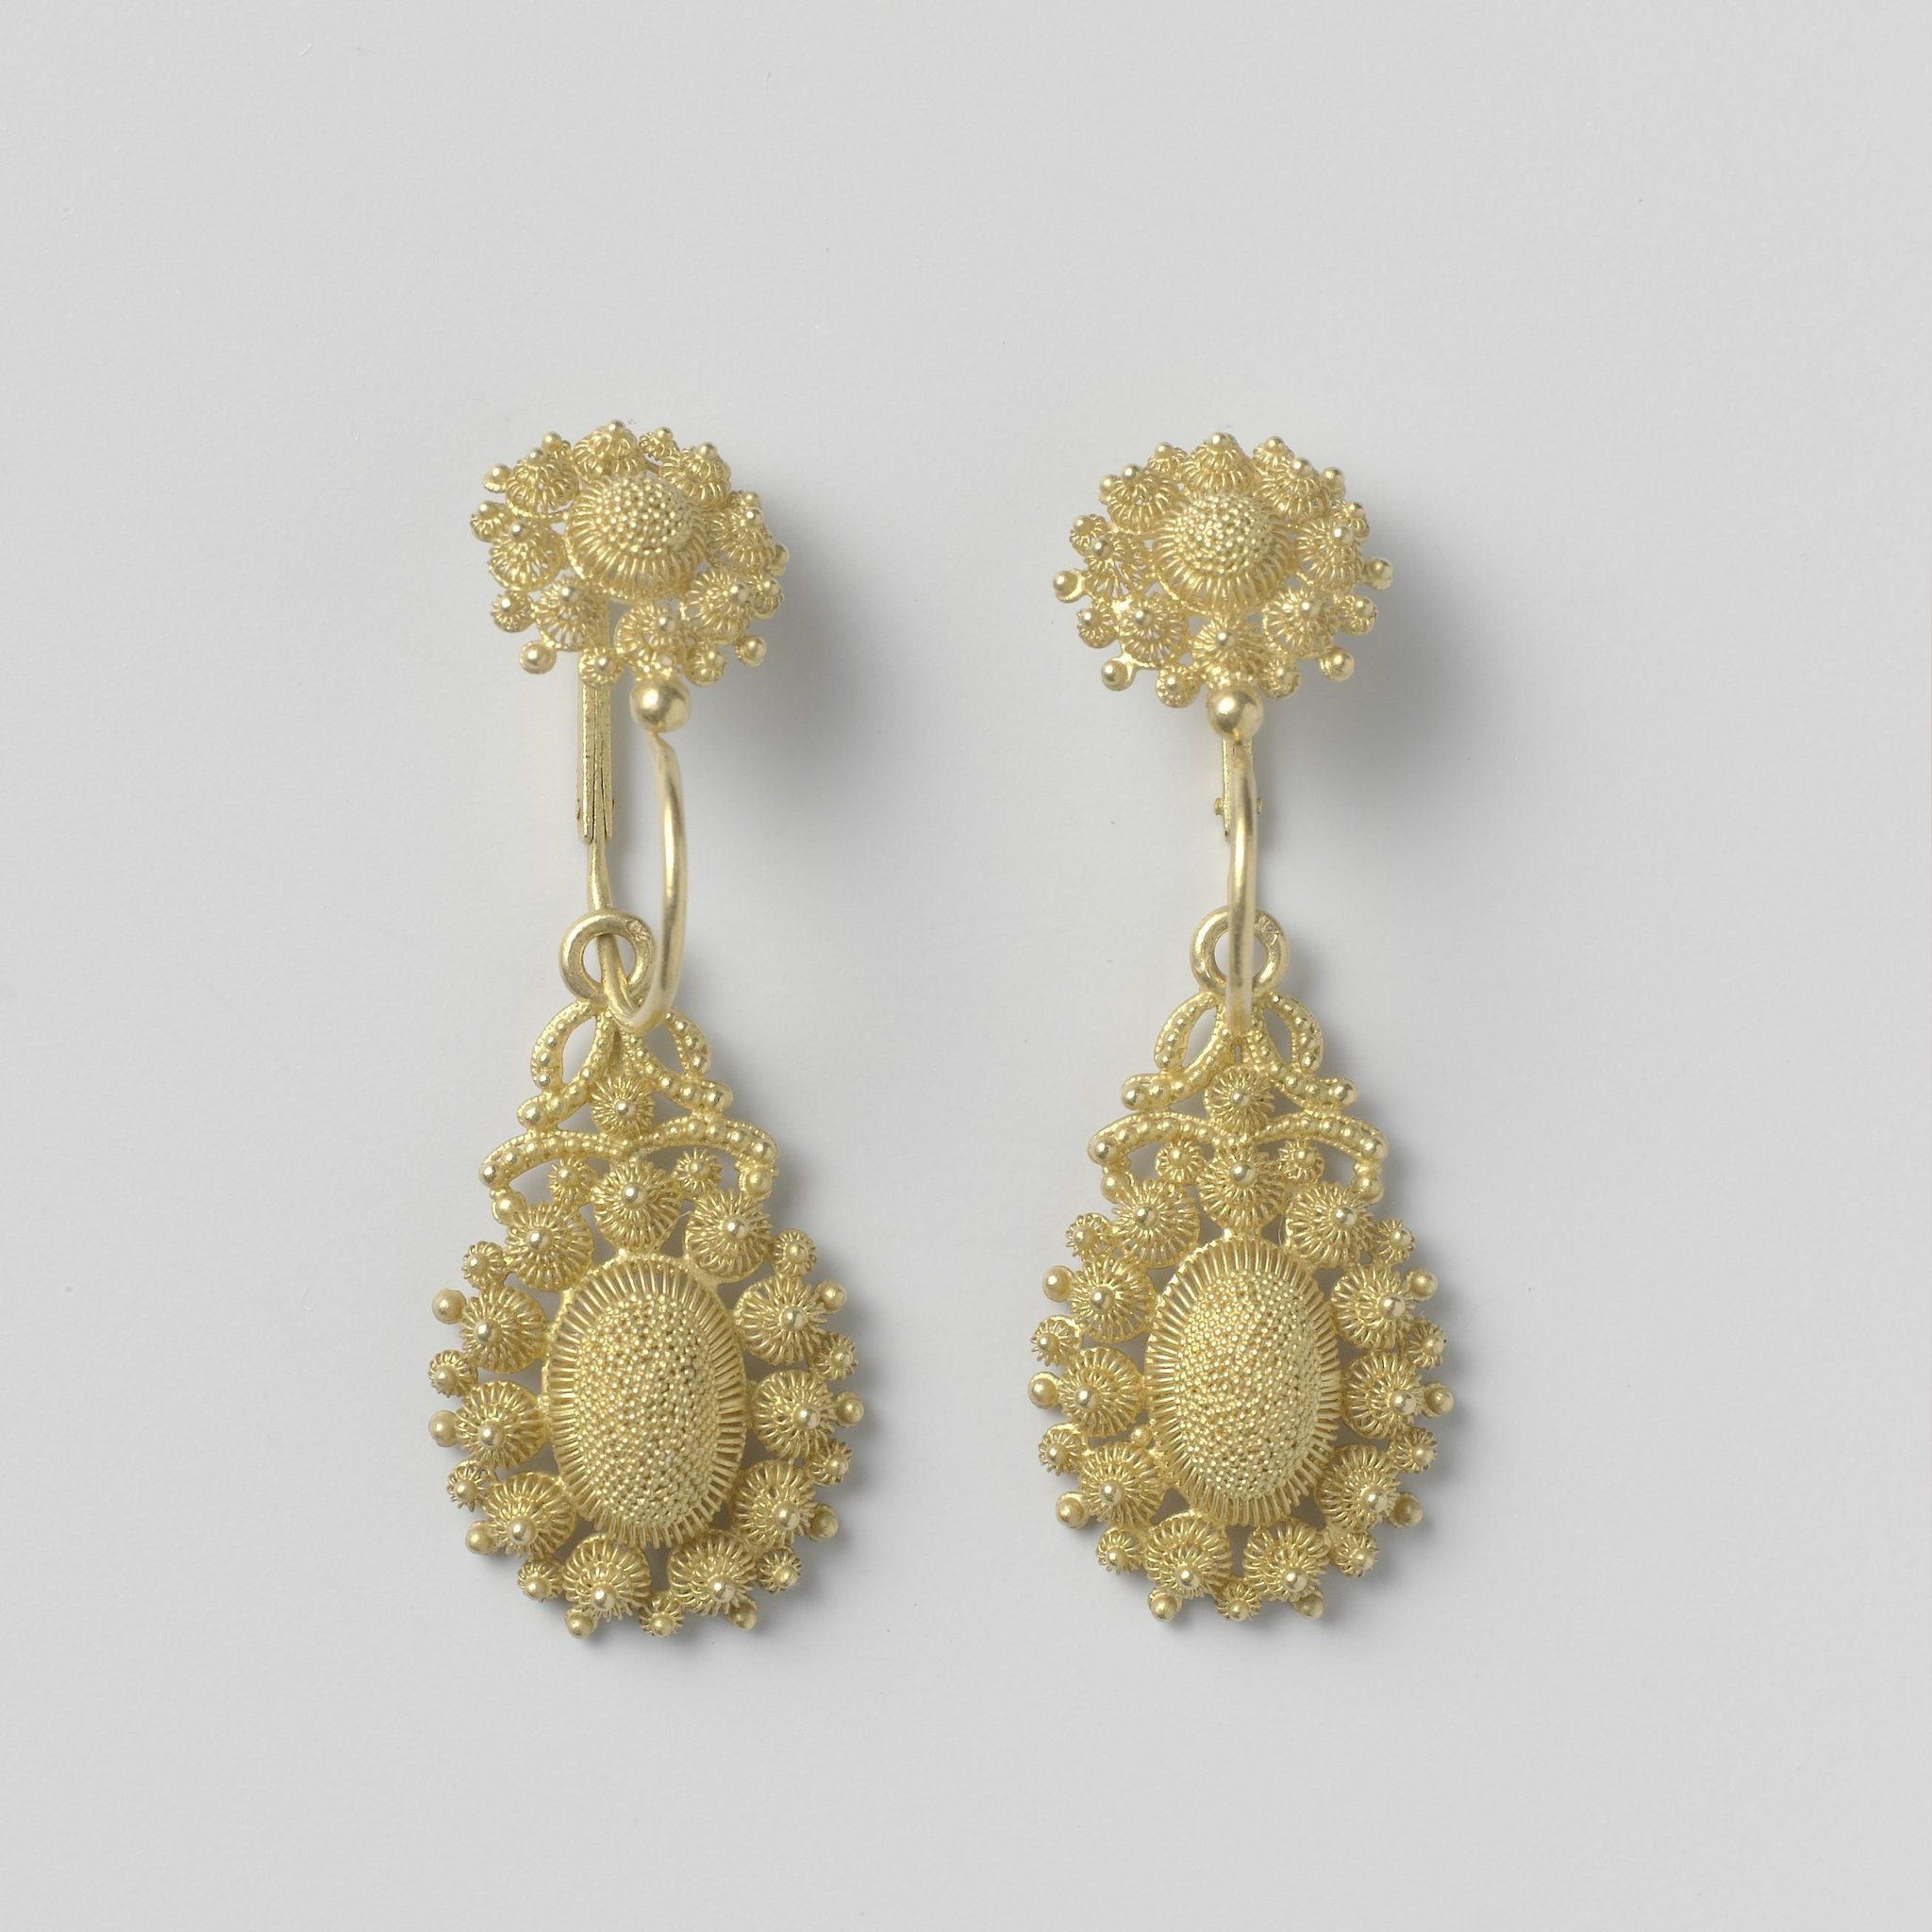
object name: ear ornament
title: Stel oorhangers, deel van een demi-parure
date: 1824-1838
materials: gold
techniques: filigree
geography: amsterdam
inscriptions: maker's mark: ‘PC waartussen een anker in zeshoek’, alloy mark: ‘leeuwenkop naar links (Nederland 1813-1906)’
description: Een stel oorhangers van goud. Uitgevoerd in filigrein.